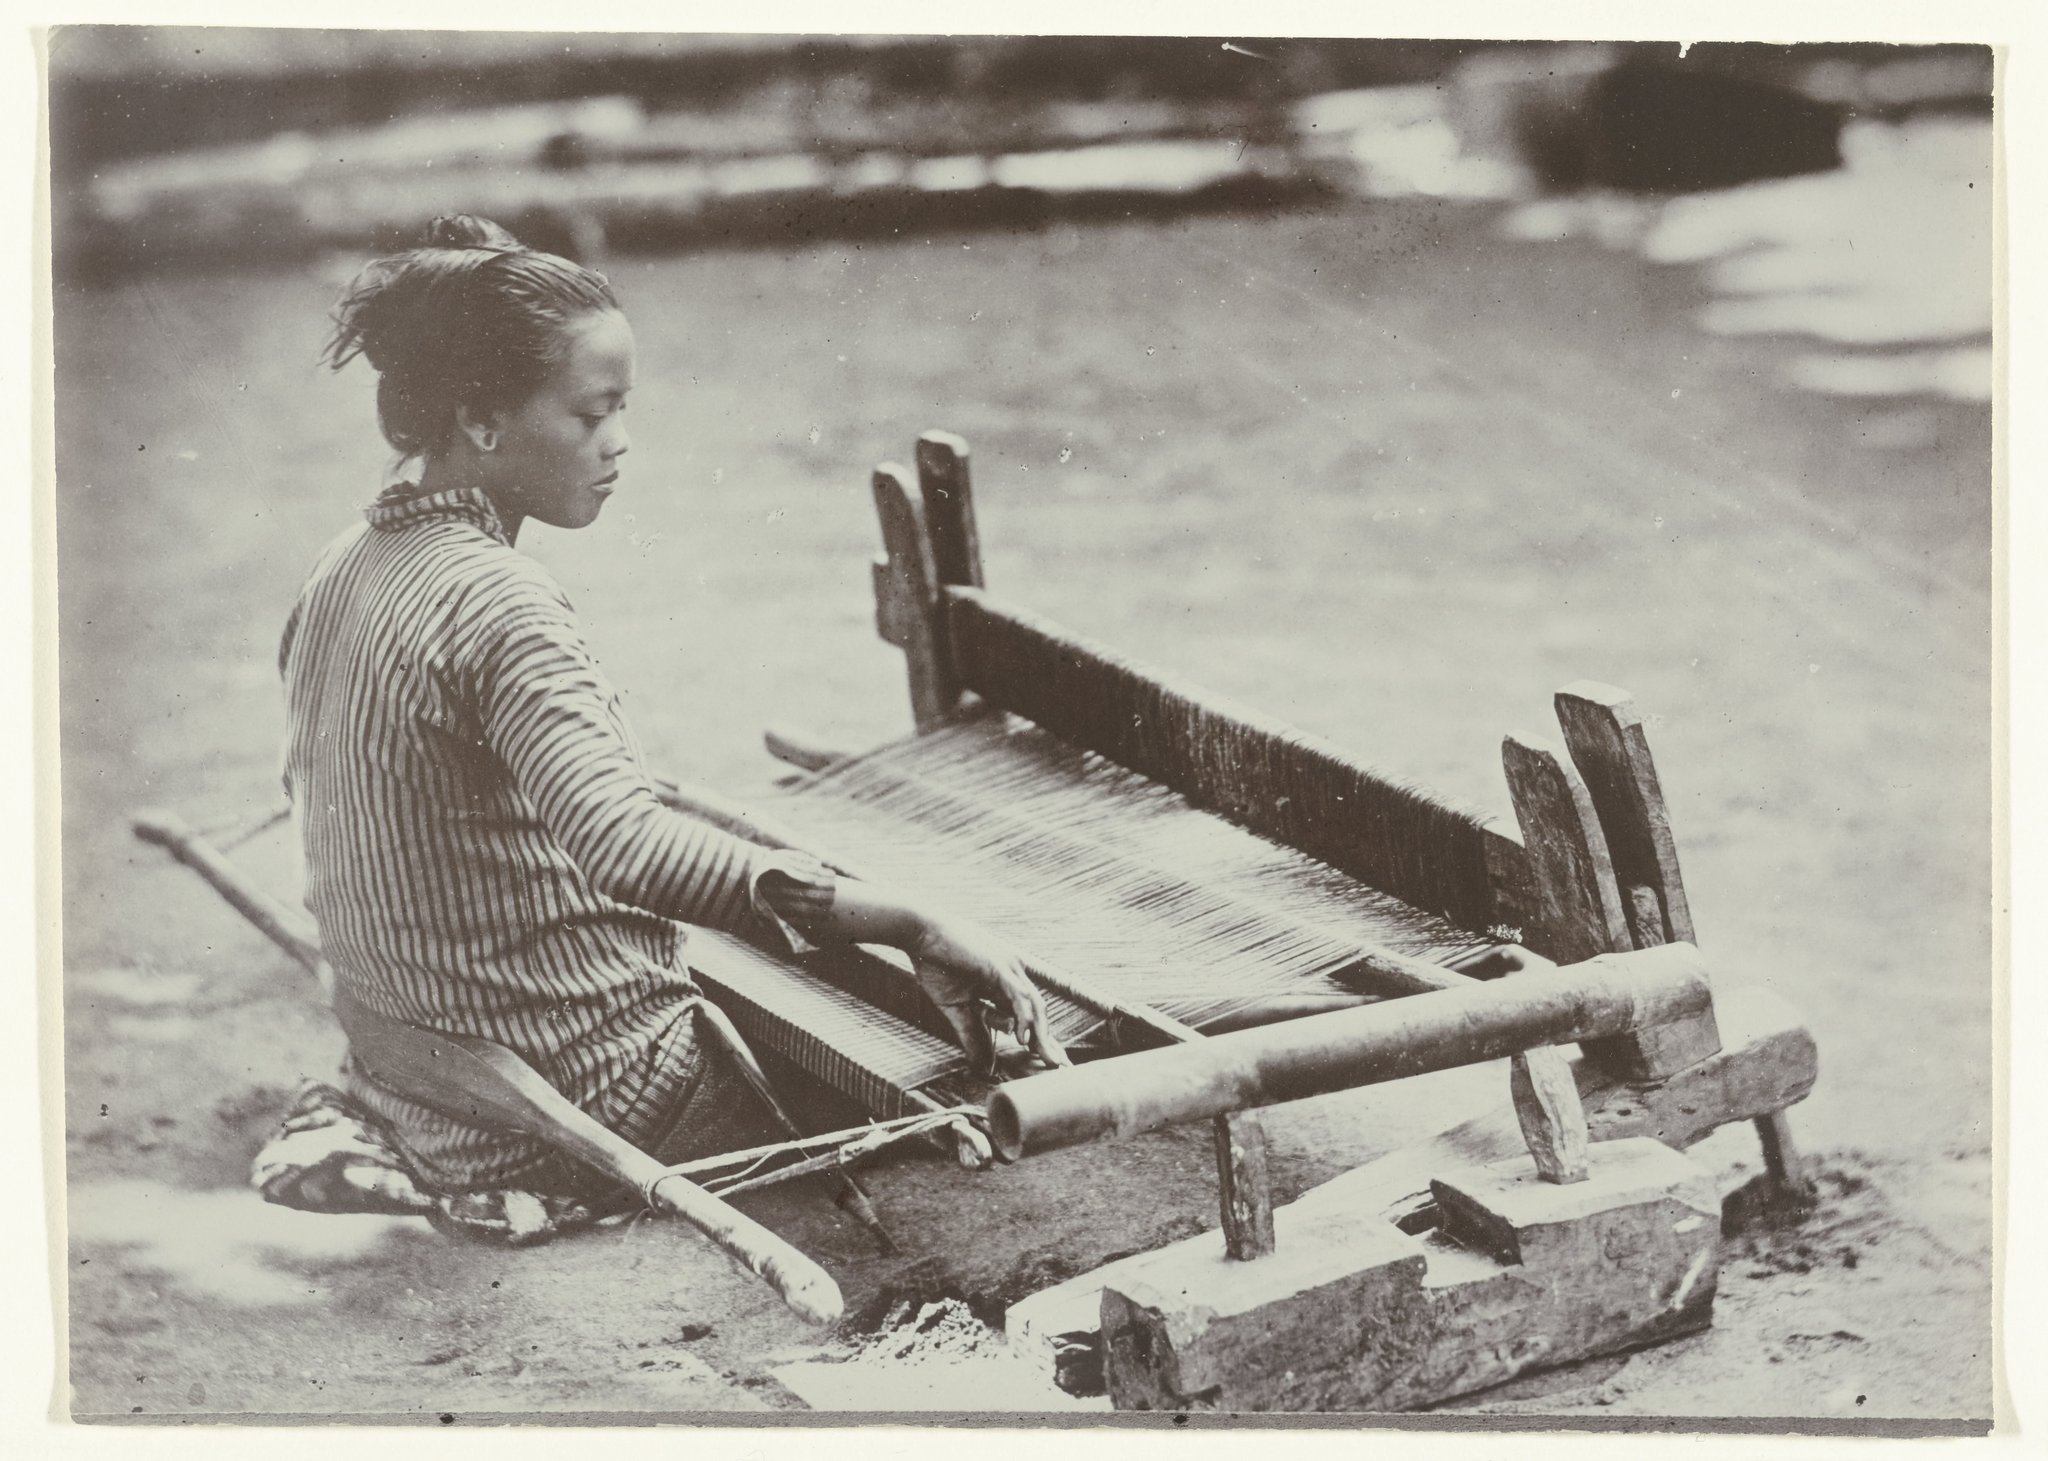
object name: photograph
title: Javanese Woman Weaving Cloth on a Loom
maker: kassian céphas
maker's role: fotograaf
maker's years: 1845-1912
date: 1867-1910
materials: cardboard, paper, photographic support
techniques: albumen print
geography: java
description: Photographs of traditional crafts were popular with European visitors to Asia. The sultan of Yogyakarta’s court supported many traditional cotton and silk weavers. This young woman uses a backstrap loom, keeping tension on the warp threads by leaning her back against a wooden beam.